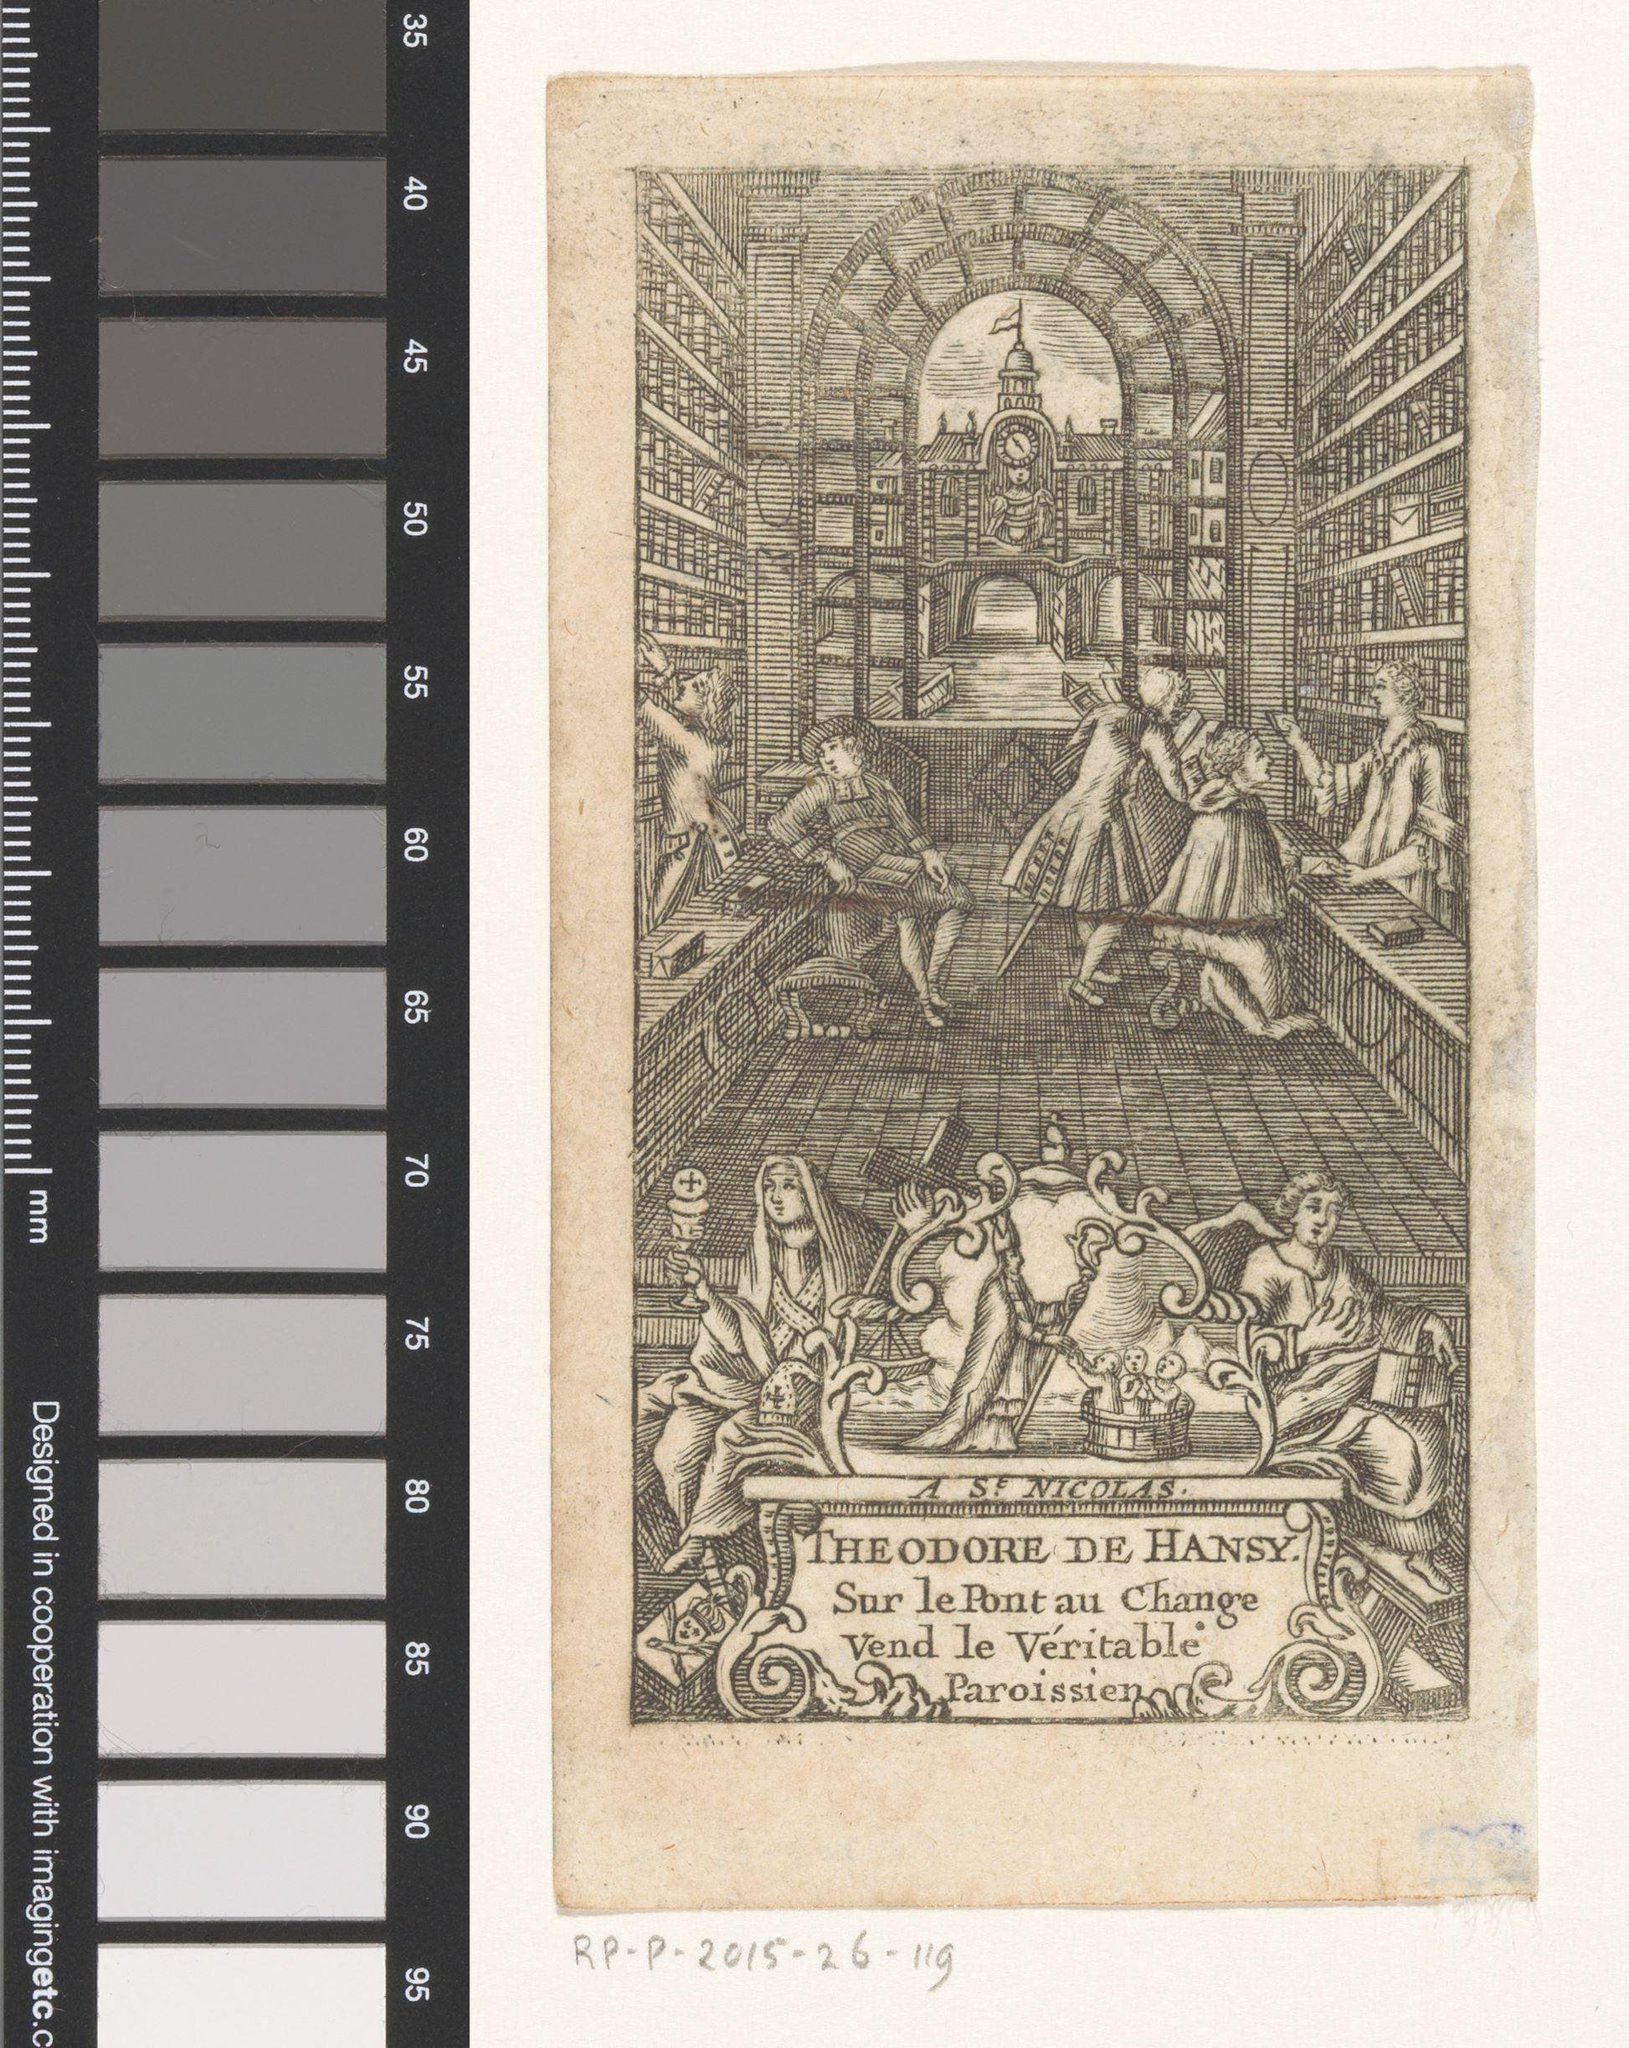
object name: print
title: Interieur van de boekhandel van Theodore de Hansy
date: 1726-1771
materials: paper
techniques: engraving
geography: paris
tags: bridge, st. nicholas restores to life three children who had been murdered, dismembered, and salted down in a pickling tub by an inn-keeper, book-shop, bookseller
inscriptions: collector's mark: Lugt 2228, collector's mark: Lugt 4780, annotation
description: Interieur van de winkel van uitgever en boekverkoper Theodore de Hansy op de Pont au Change te Parijs. Aan weerszijden van het vertrek hoge boekenkasten en een toonbank. Het raam biedt uitzicht op de Pont Neuf met de pomp La Samaritaine. Het adres van De Hansy onder een cartouche met de H. Nicolaas en de ton met drie kinderen.